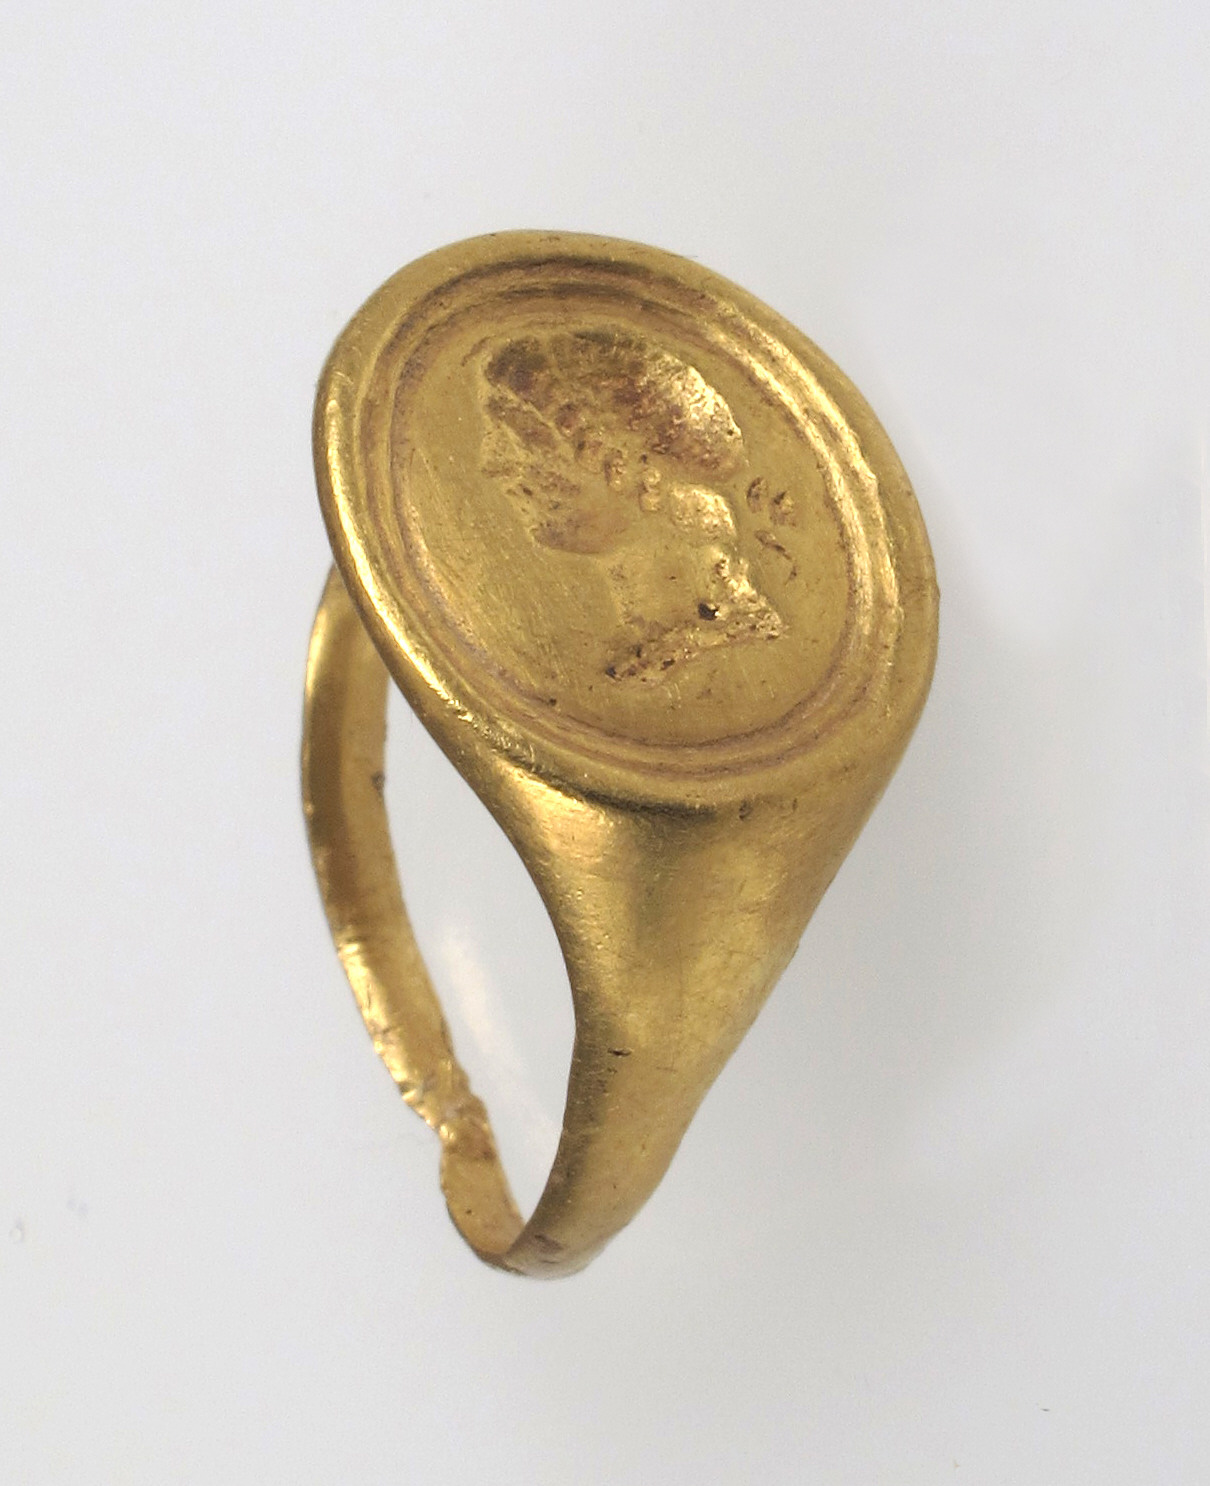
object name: ring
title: Finger Ring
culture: frankish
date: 500-700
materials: gold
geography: northern france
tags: human figures,profiles